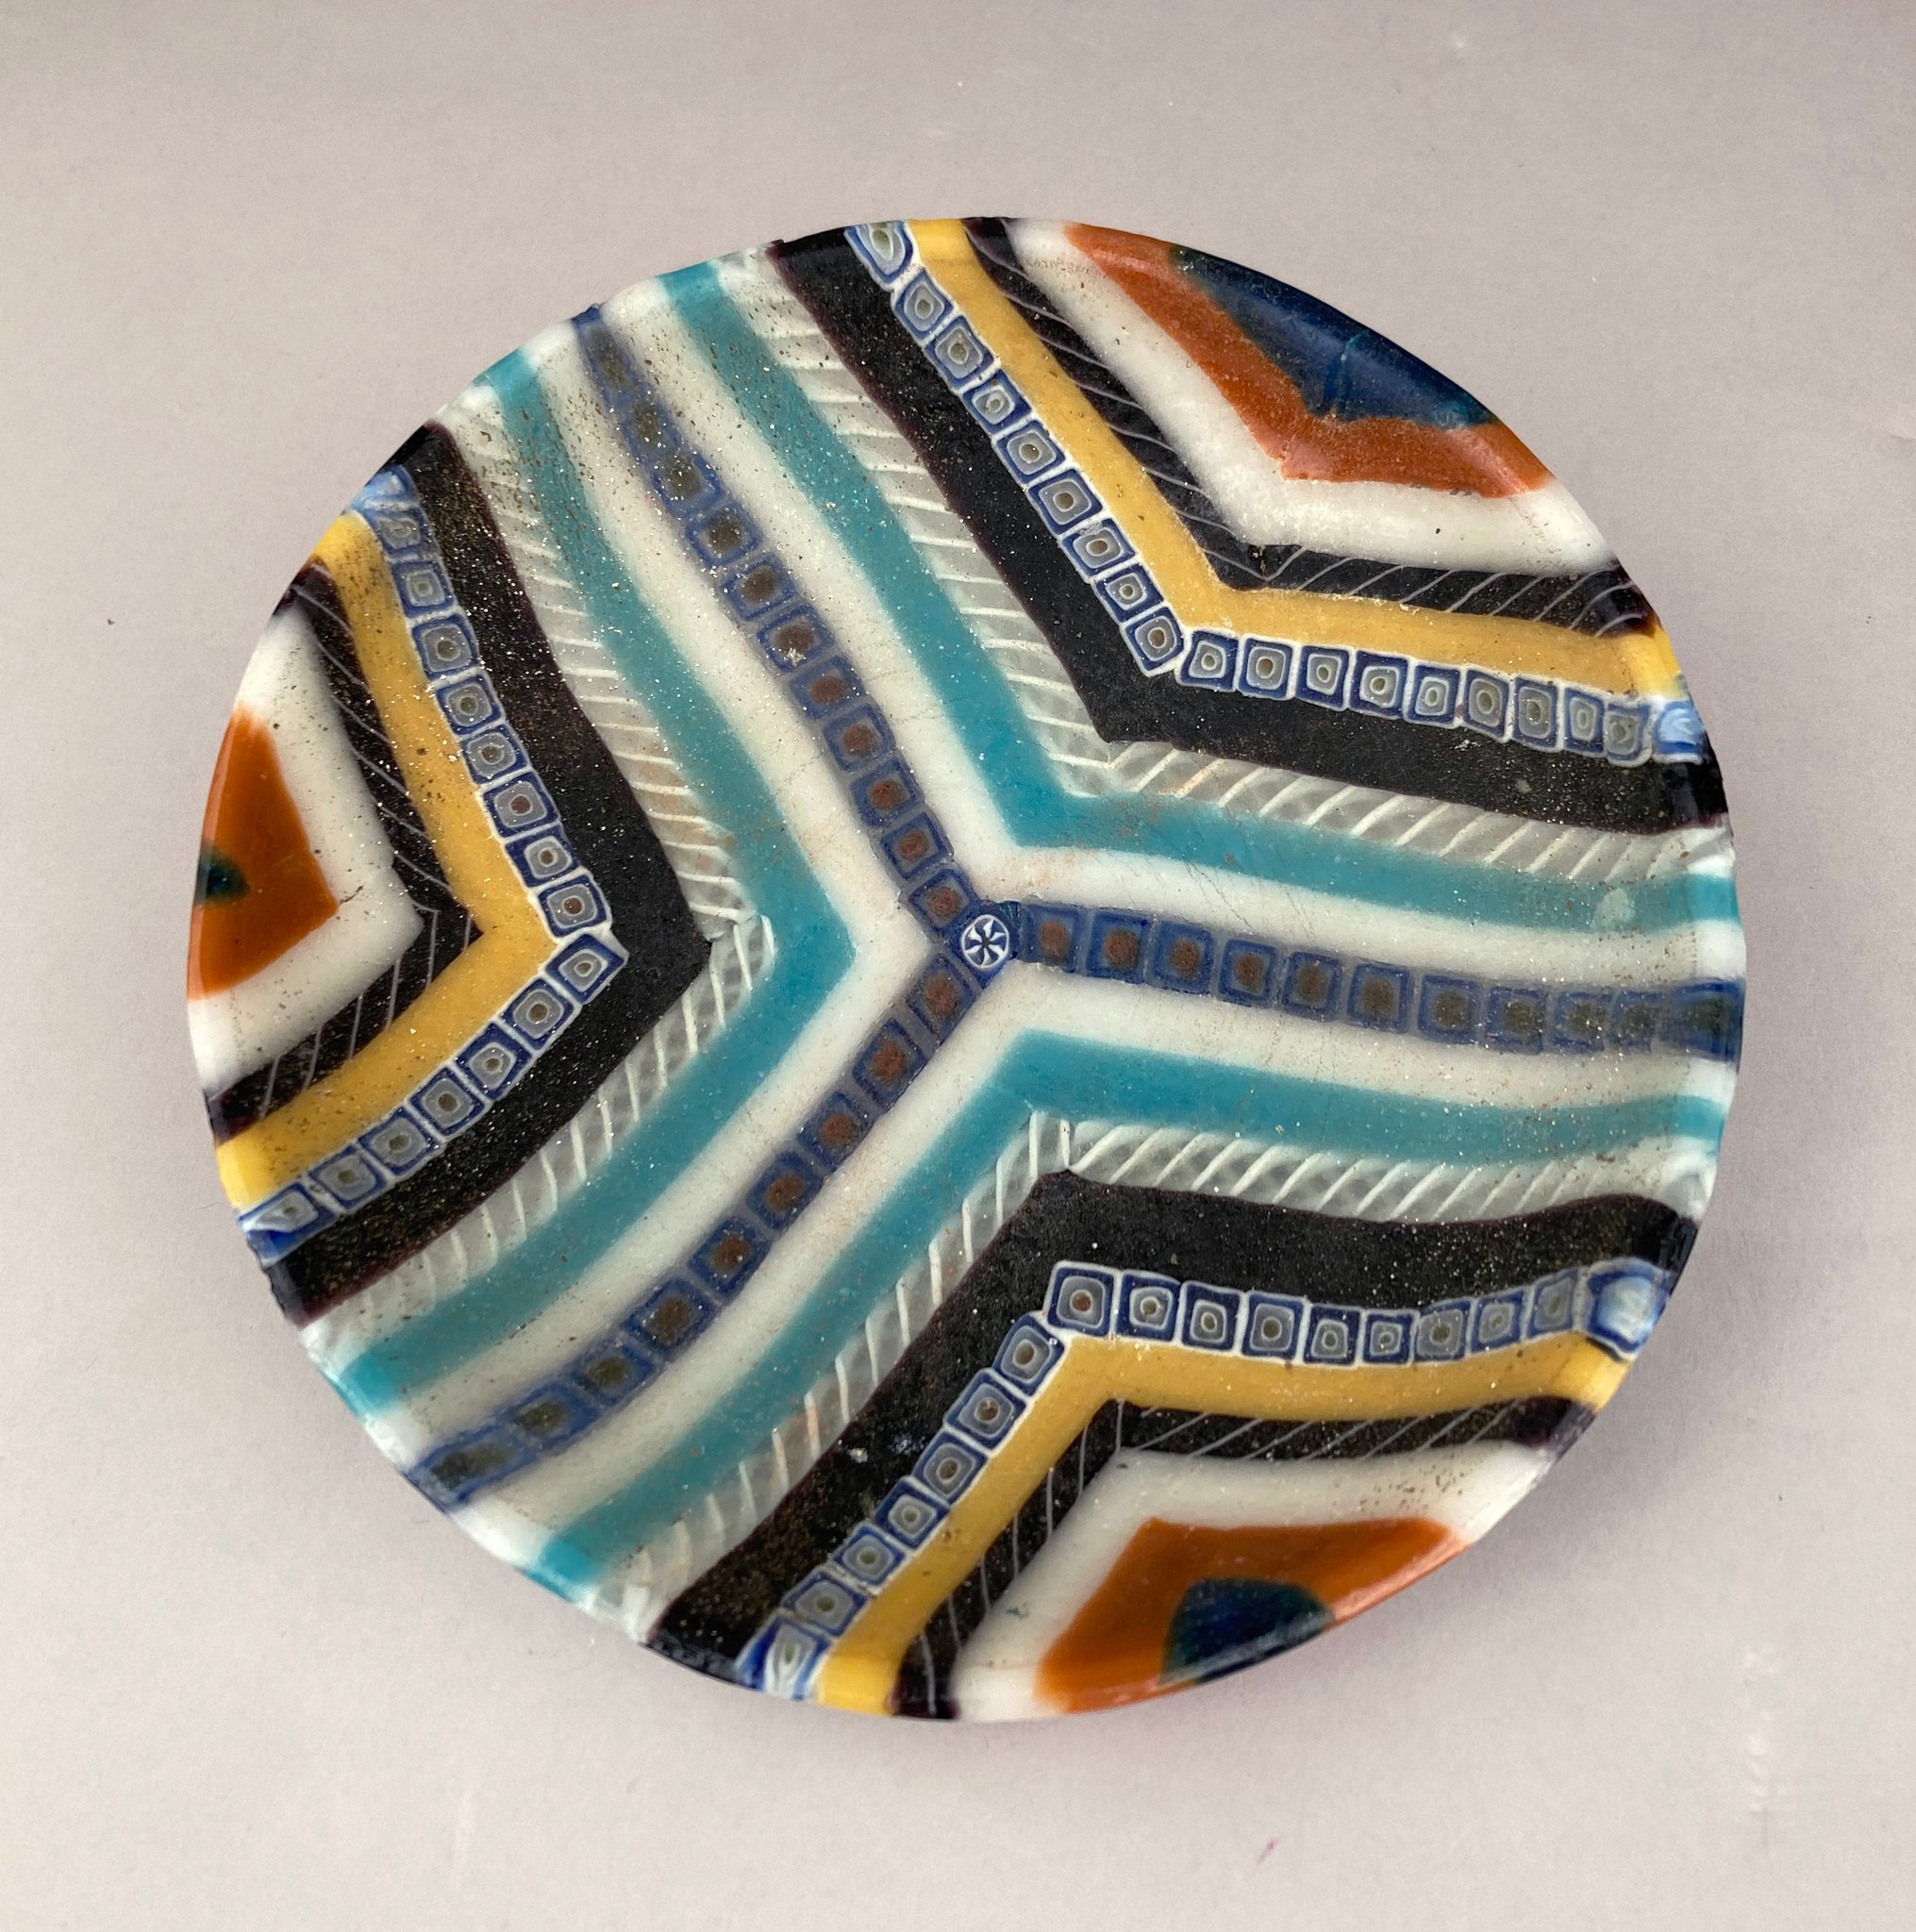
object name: bowl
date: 1881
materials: glass